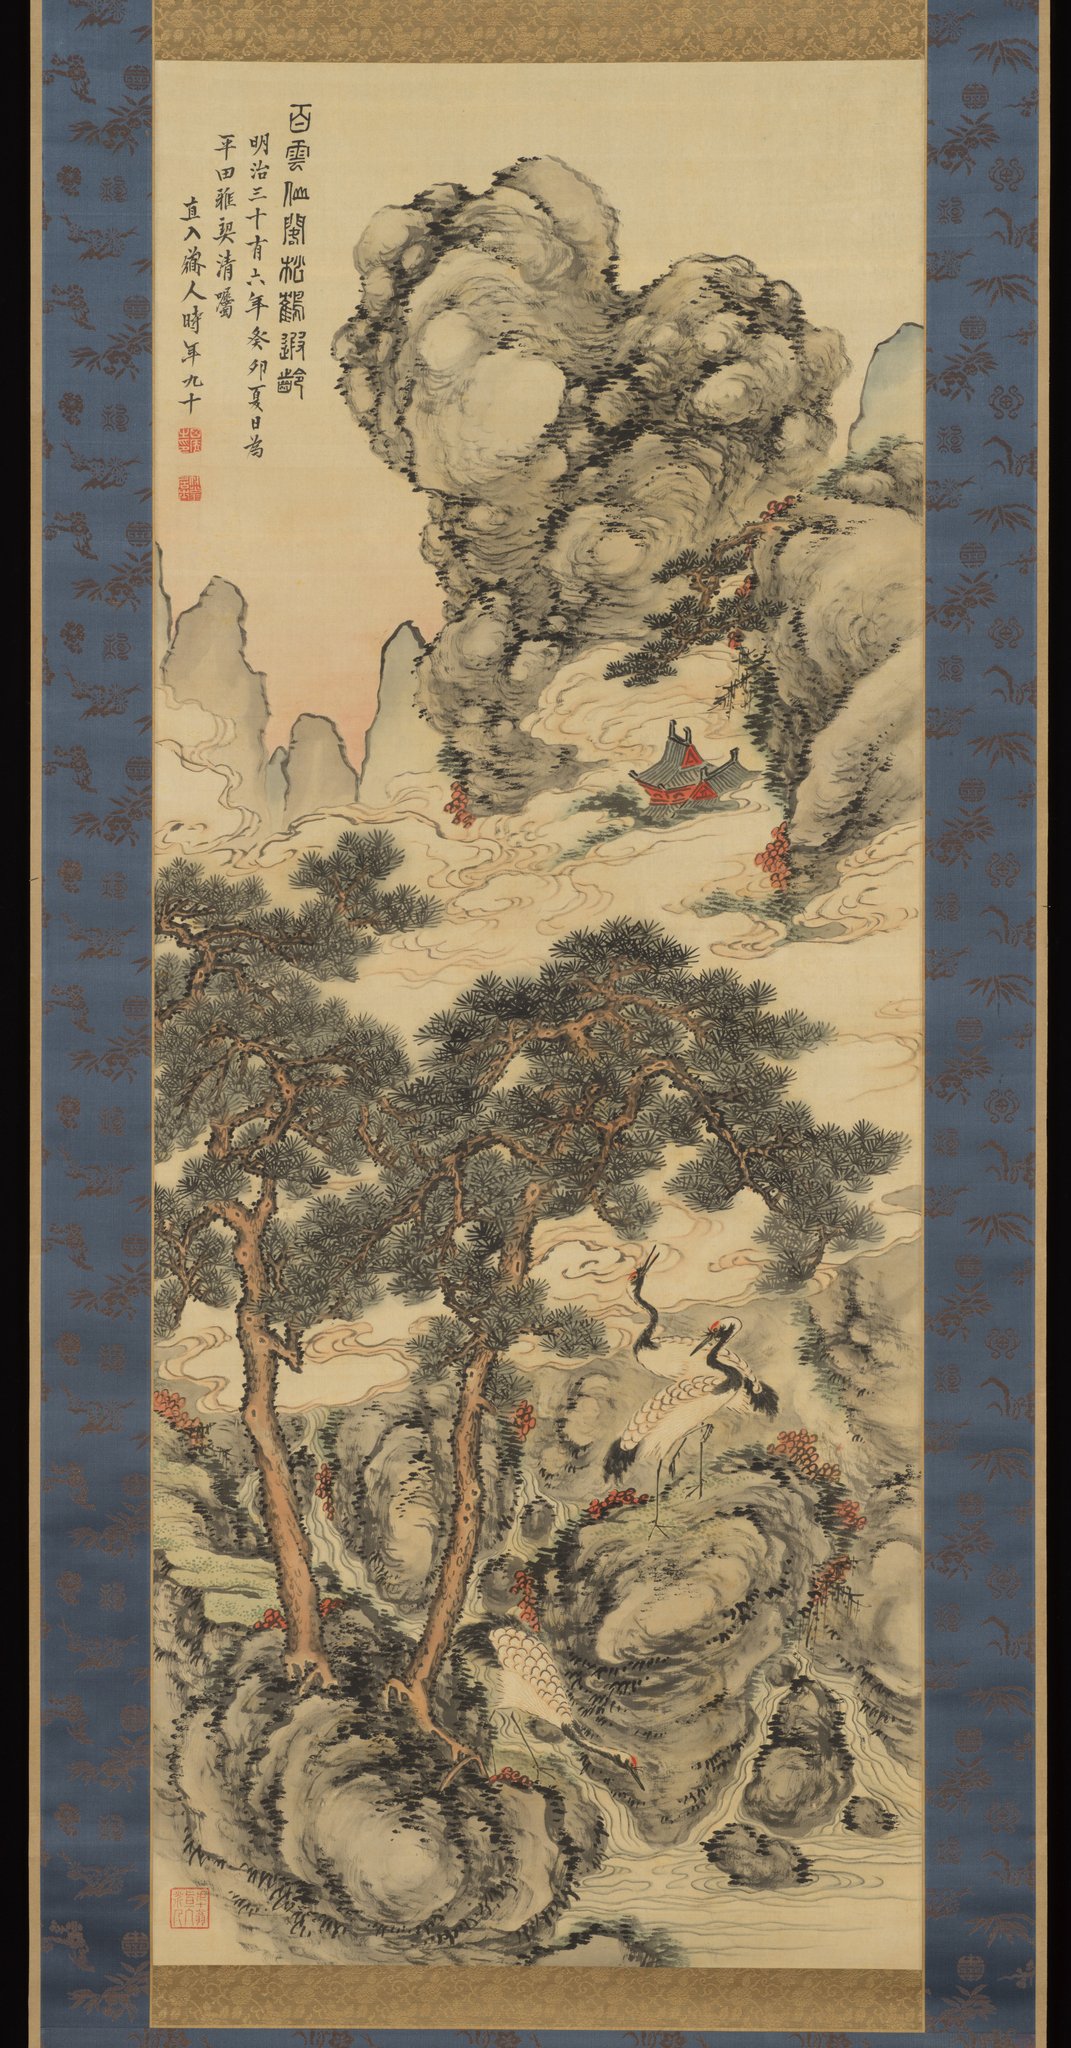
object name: hanging scroll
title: Pines and Cranes of Longevity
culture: japanese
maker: tanomura chokunyū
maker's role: artist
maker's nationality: japanese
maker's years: 1814-1907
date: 1903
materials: ink, silk